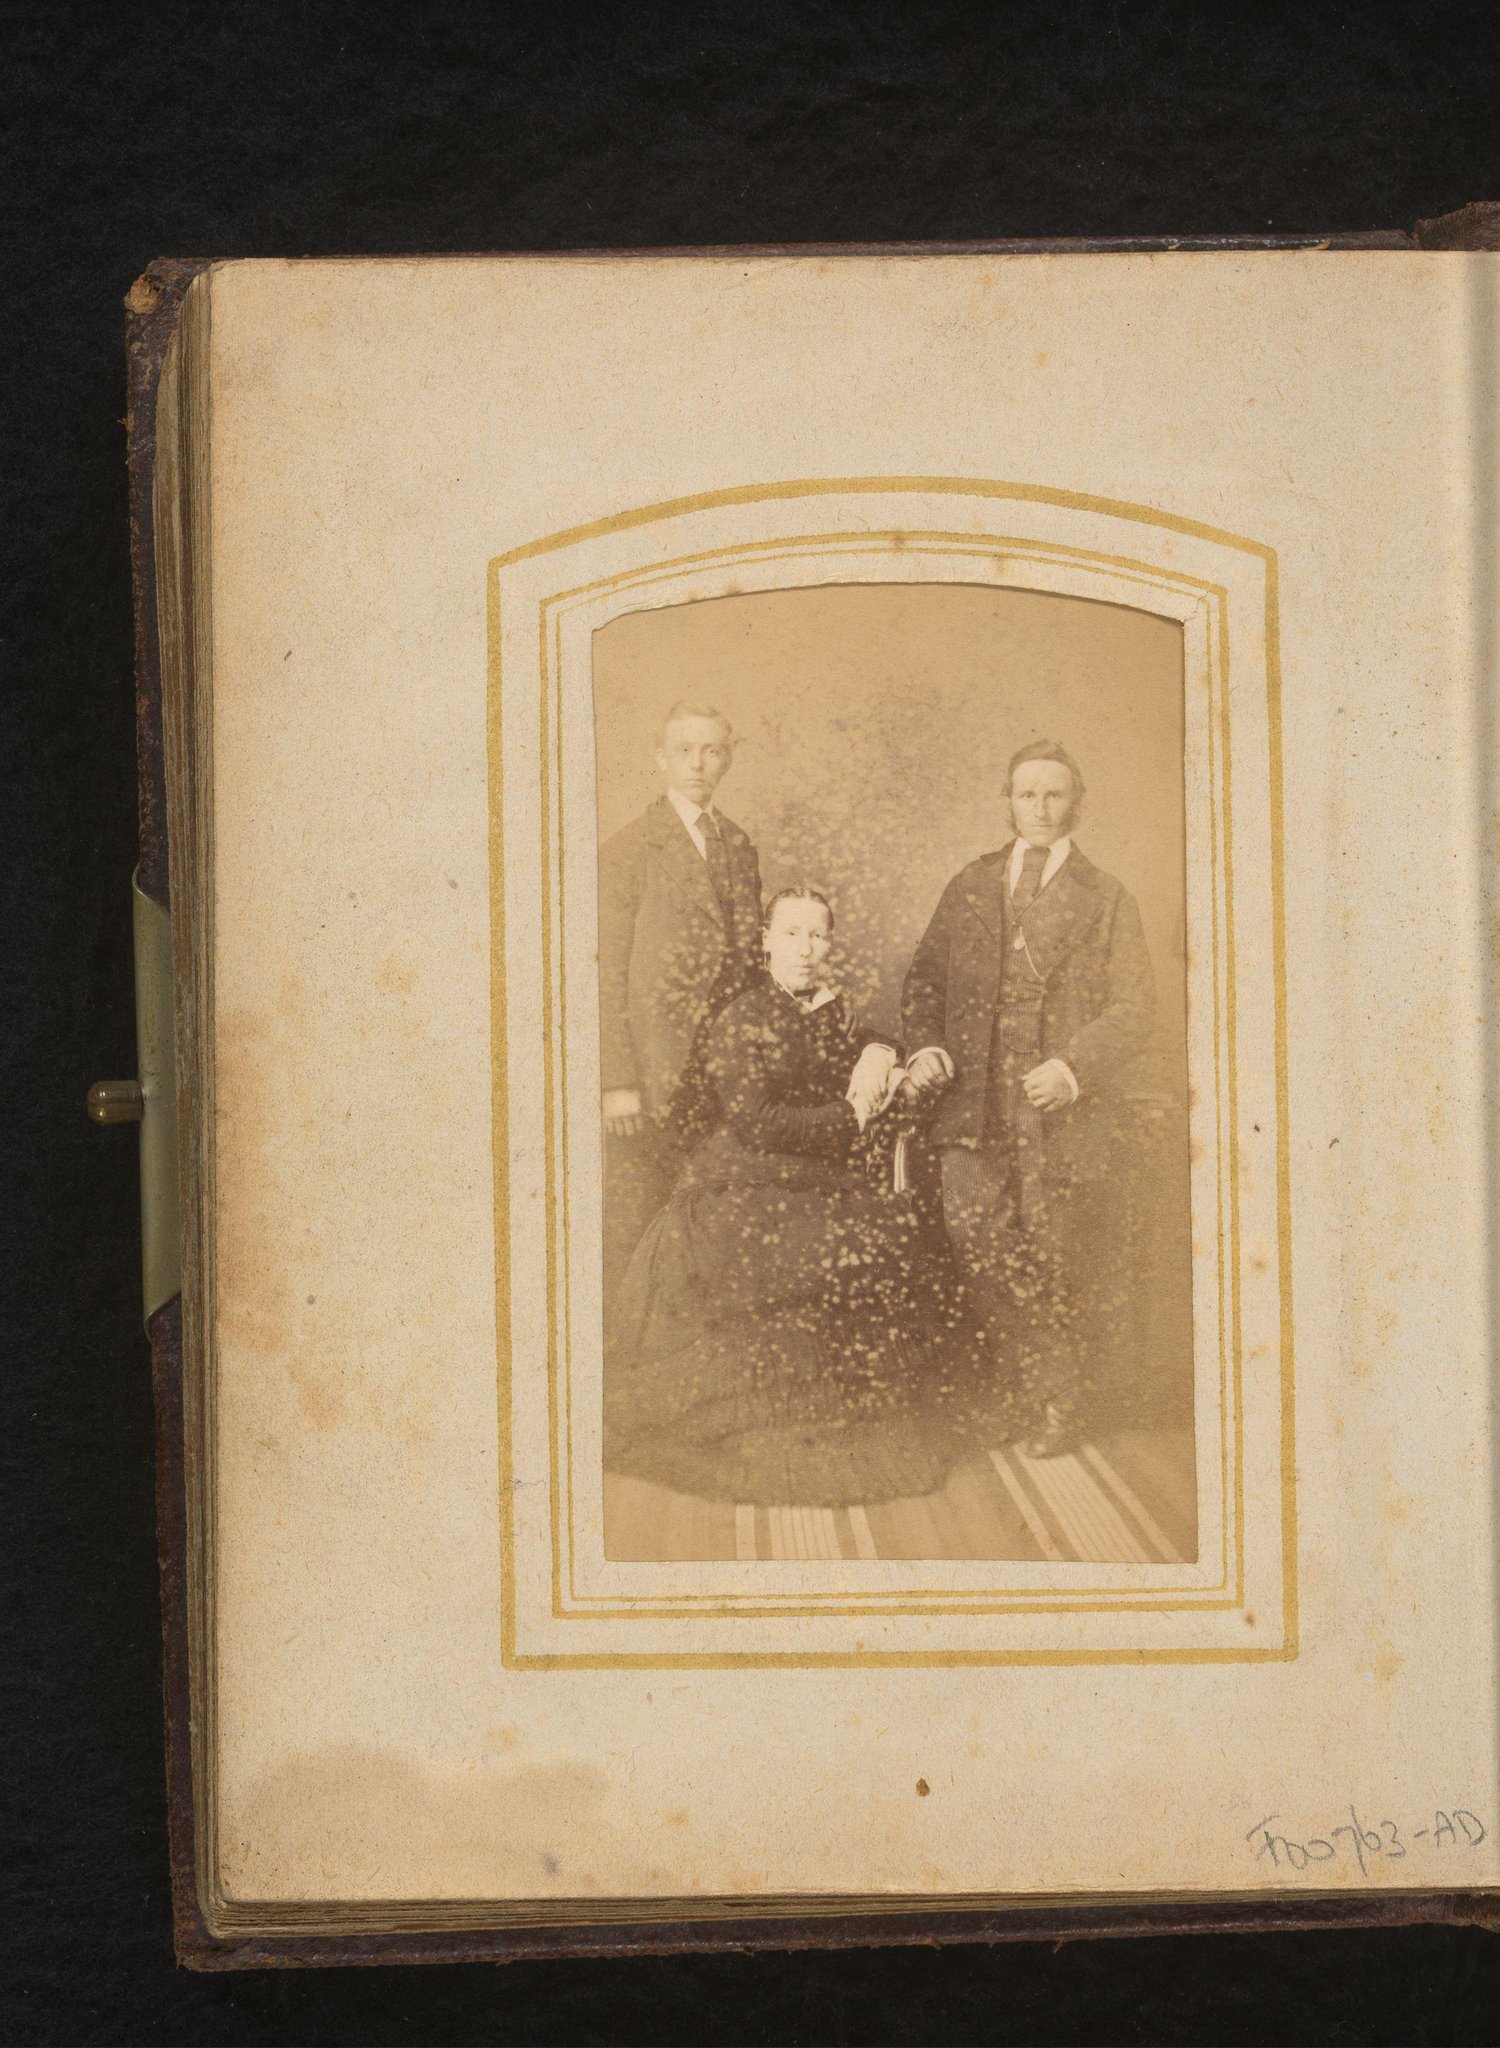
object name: album leaf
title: Portret van een zittende vrouw en twee staande mannen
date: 1870-1890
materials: cardboard, photographic support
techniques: albumen print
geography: zwolle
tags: adult man (+ two persons), sitting figure - aa - female human figure, historical persons - bb - woman, historical persons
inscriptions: inscription: ‘Cohen's/ Photografische Inrigting/ Nieuwstraat/ Zwolle./ Van deze photographie kan steeds nabesteld worden./ Vergrootings Portretten naar Visitekaarten, glasplaten/ etc. in alle afmetingen.’